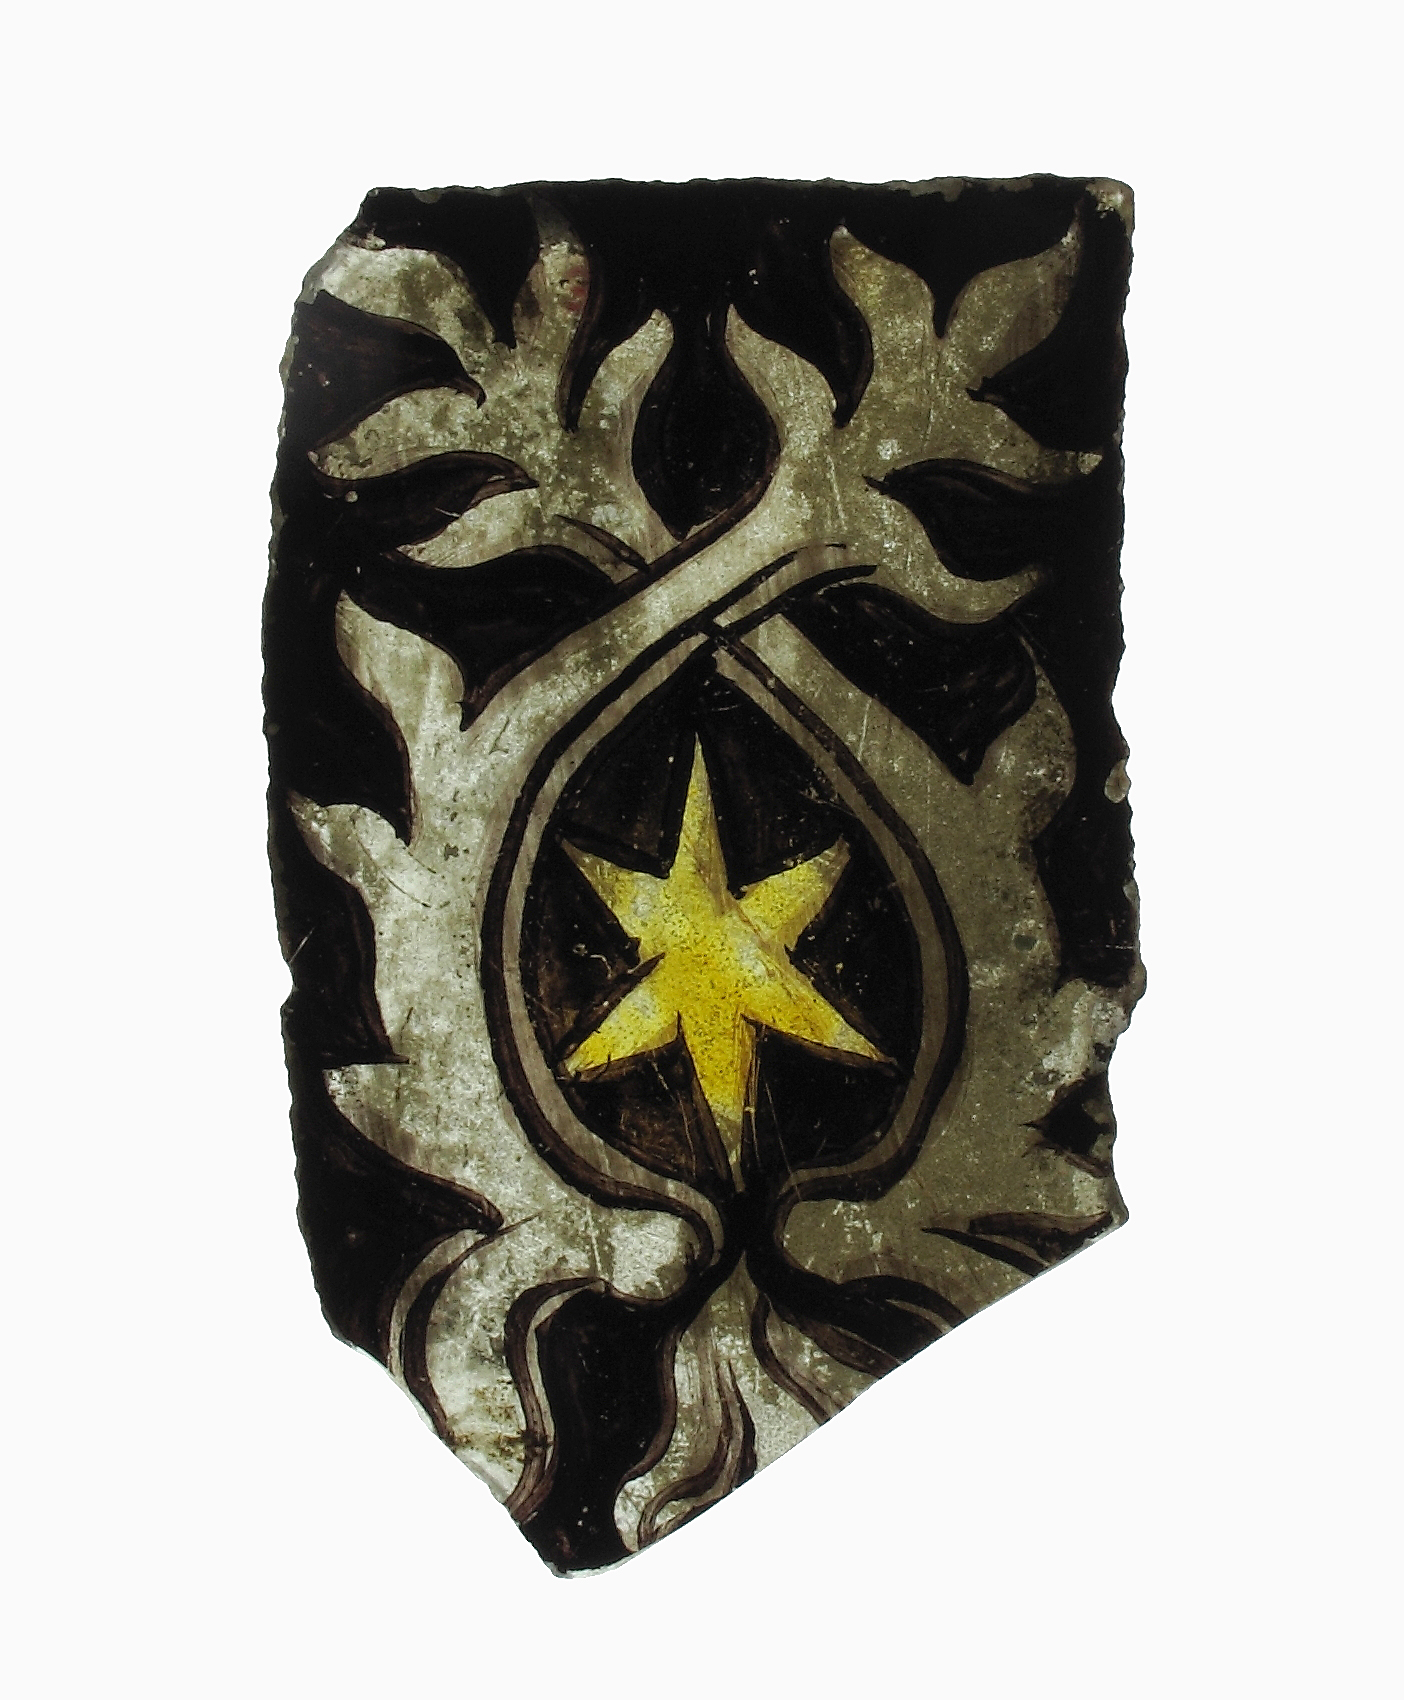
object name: fragment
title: Glass Fragment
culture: european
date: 1401-1500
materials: glass